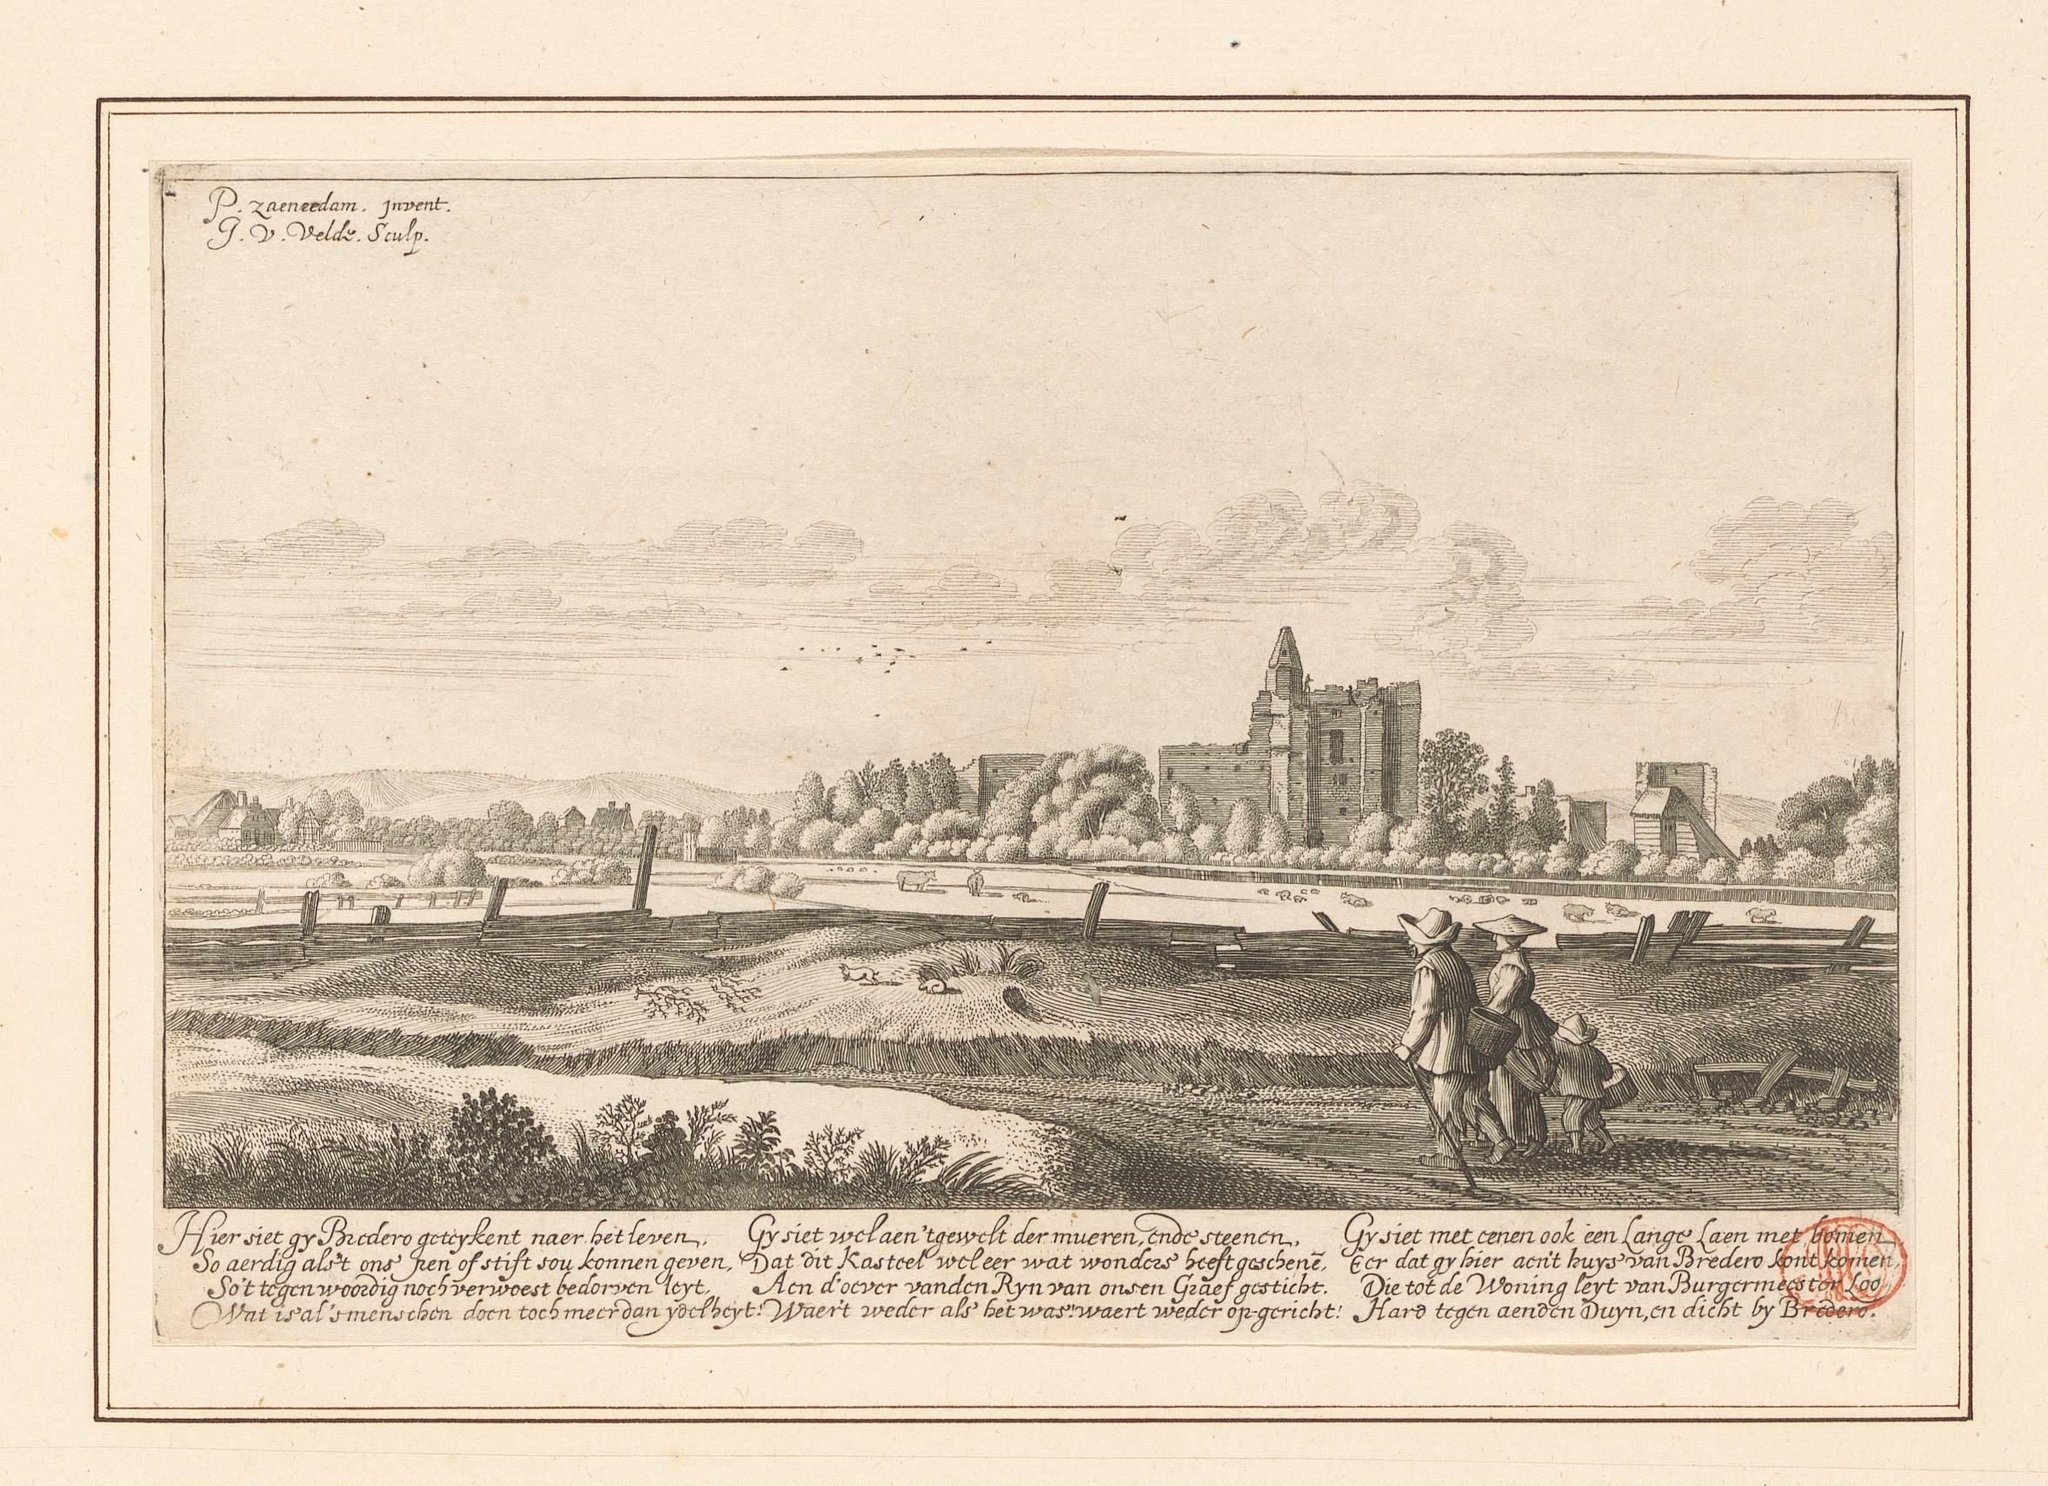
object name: print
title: Gezicht op de ruïne van Kasteel Brederode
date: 1628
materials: paper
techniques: engraving, etching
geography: haarlem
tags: landscape with ruins, ruin of a dwelling, house, castle, etc.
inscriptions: collector's mark: Lugt 195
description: Boerenfamilie op een landweg met op de achtergrond de ruïne van Kasteel Brederode te Haarlem. Onderaan een gedicht van drie verzen van vier regels in het Nederlands.